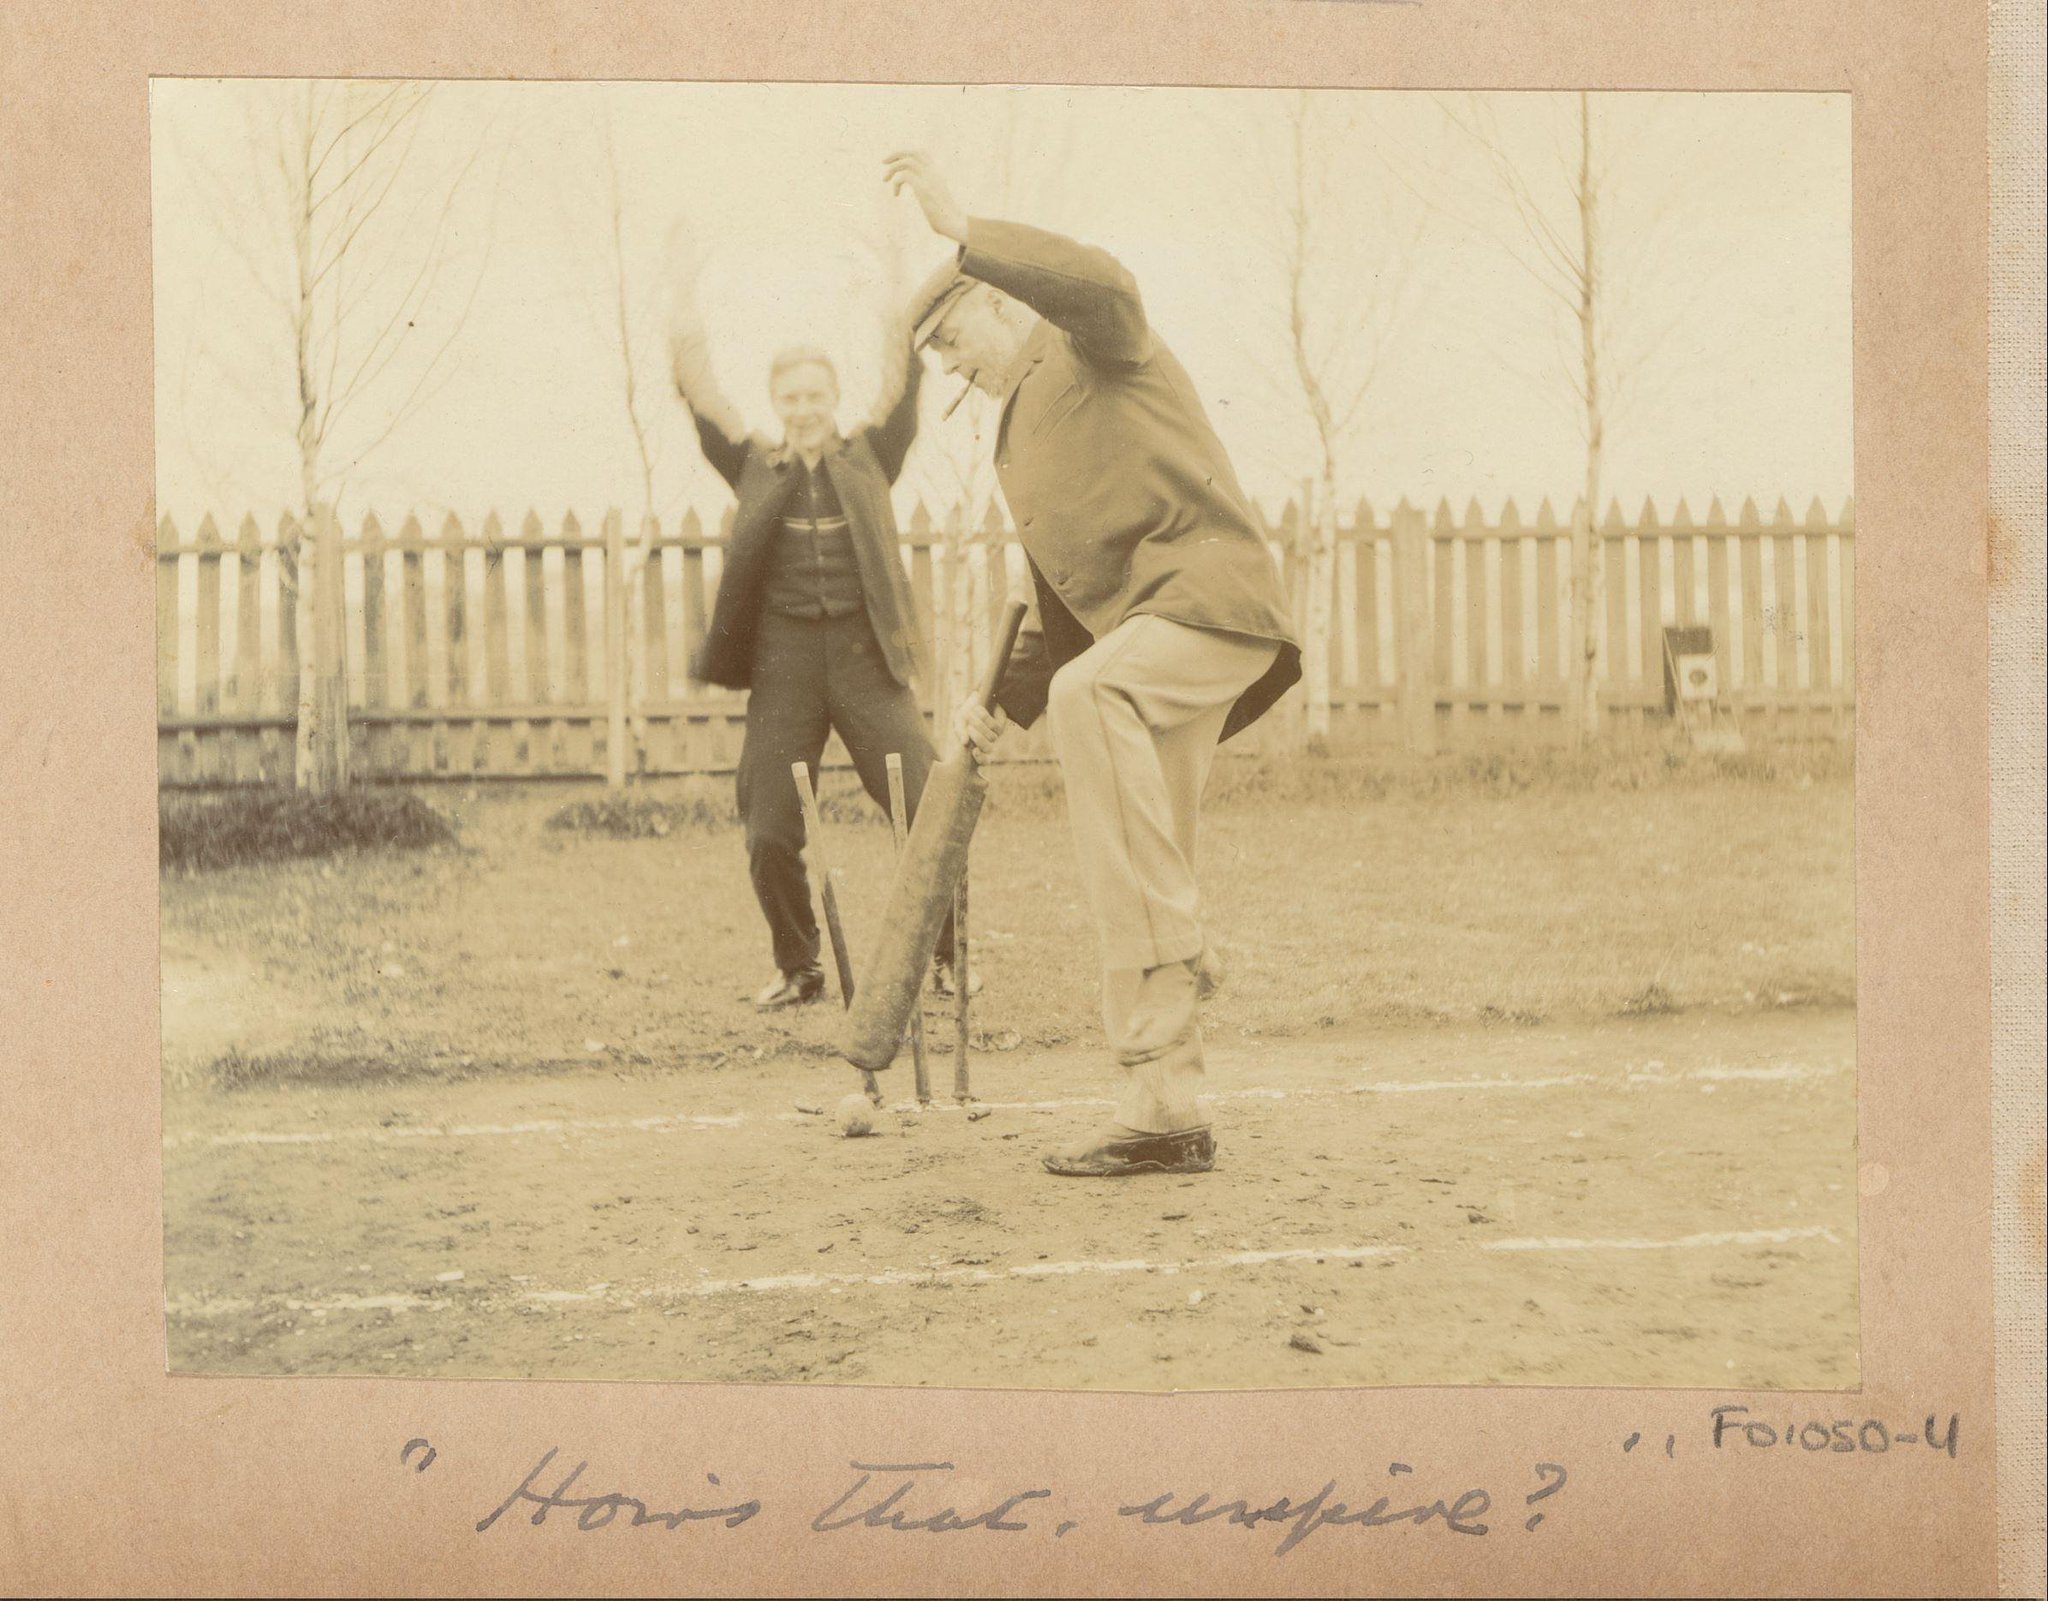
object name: photograph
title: Joseph Cheetham en andere man spelen cricket in Rusland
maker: joseph cheetham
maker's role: engineer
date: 1903-1904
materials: photographic support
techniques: gelatin silver print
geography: russia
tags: joseph cheetham, cricket (ball game) (+ sportsman, player, etc.), russia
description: Onderdeel van Fotoalbum van de Engelse familie Cheetham met opnames van hun verblijf in Rusland.